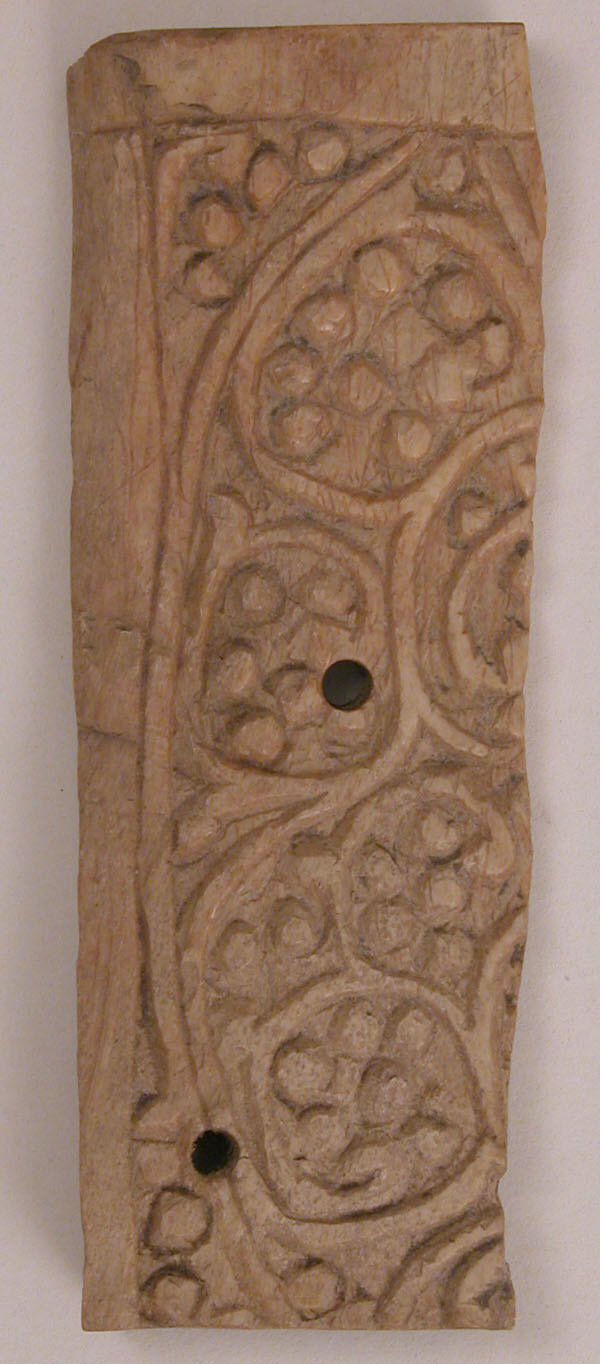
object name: plaque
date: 601-800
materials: bone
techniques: carving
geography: egypt